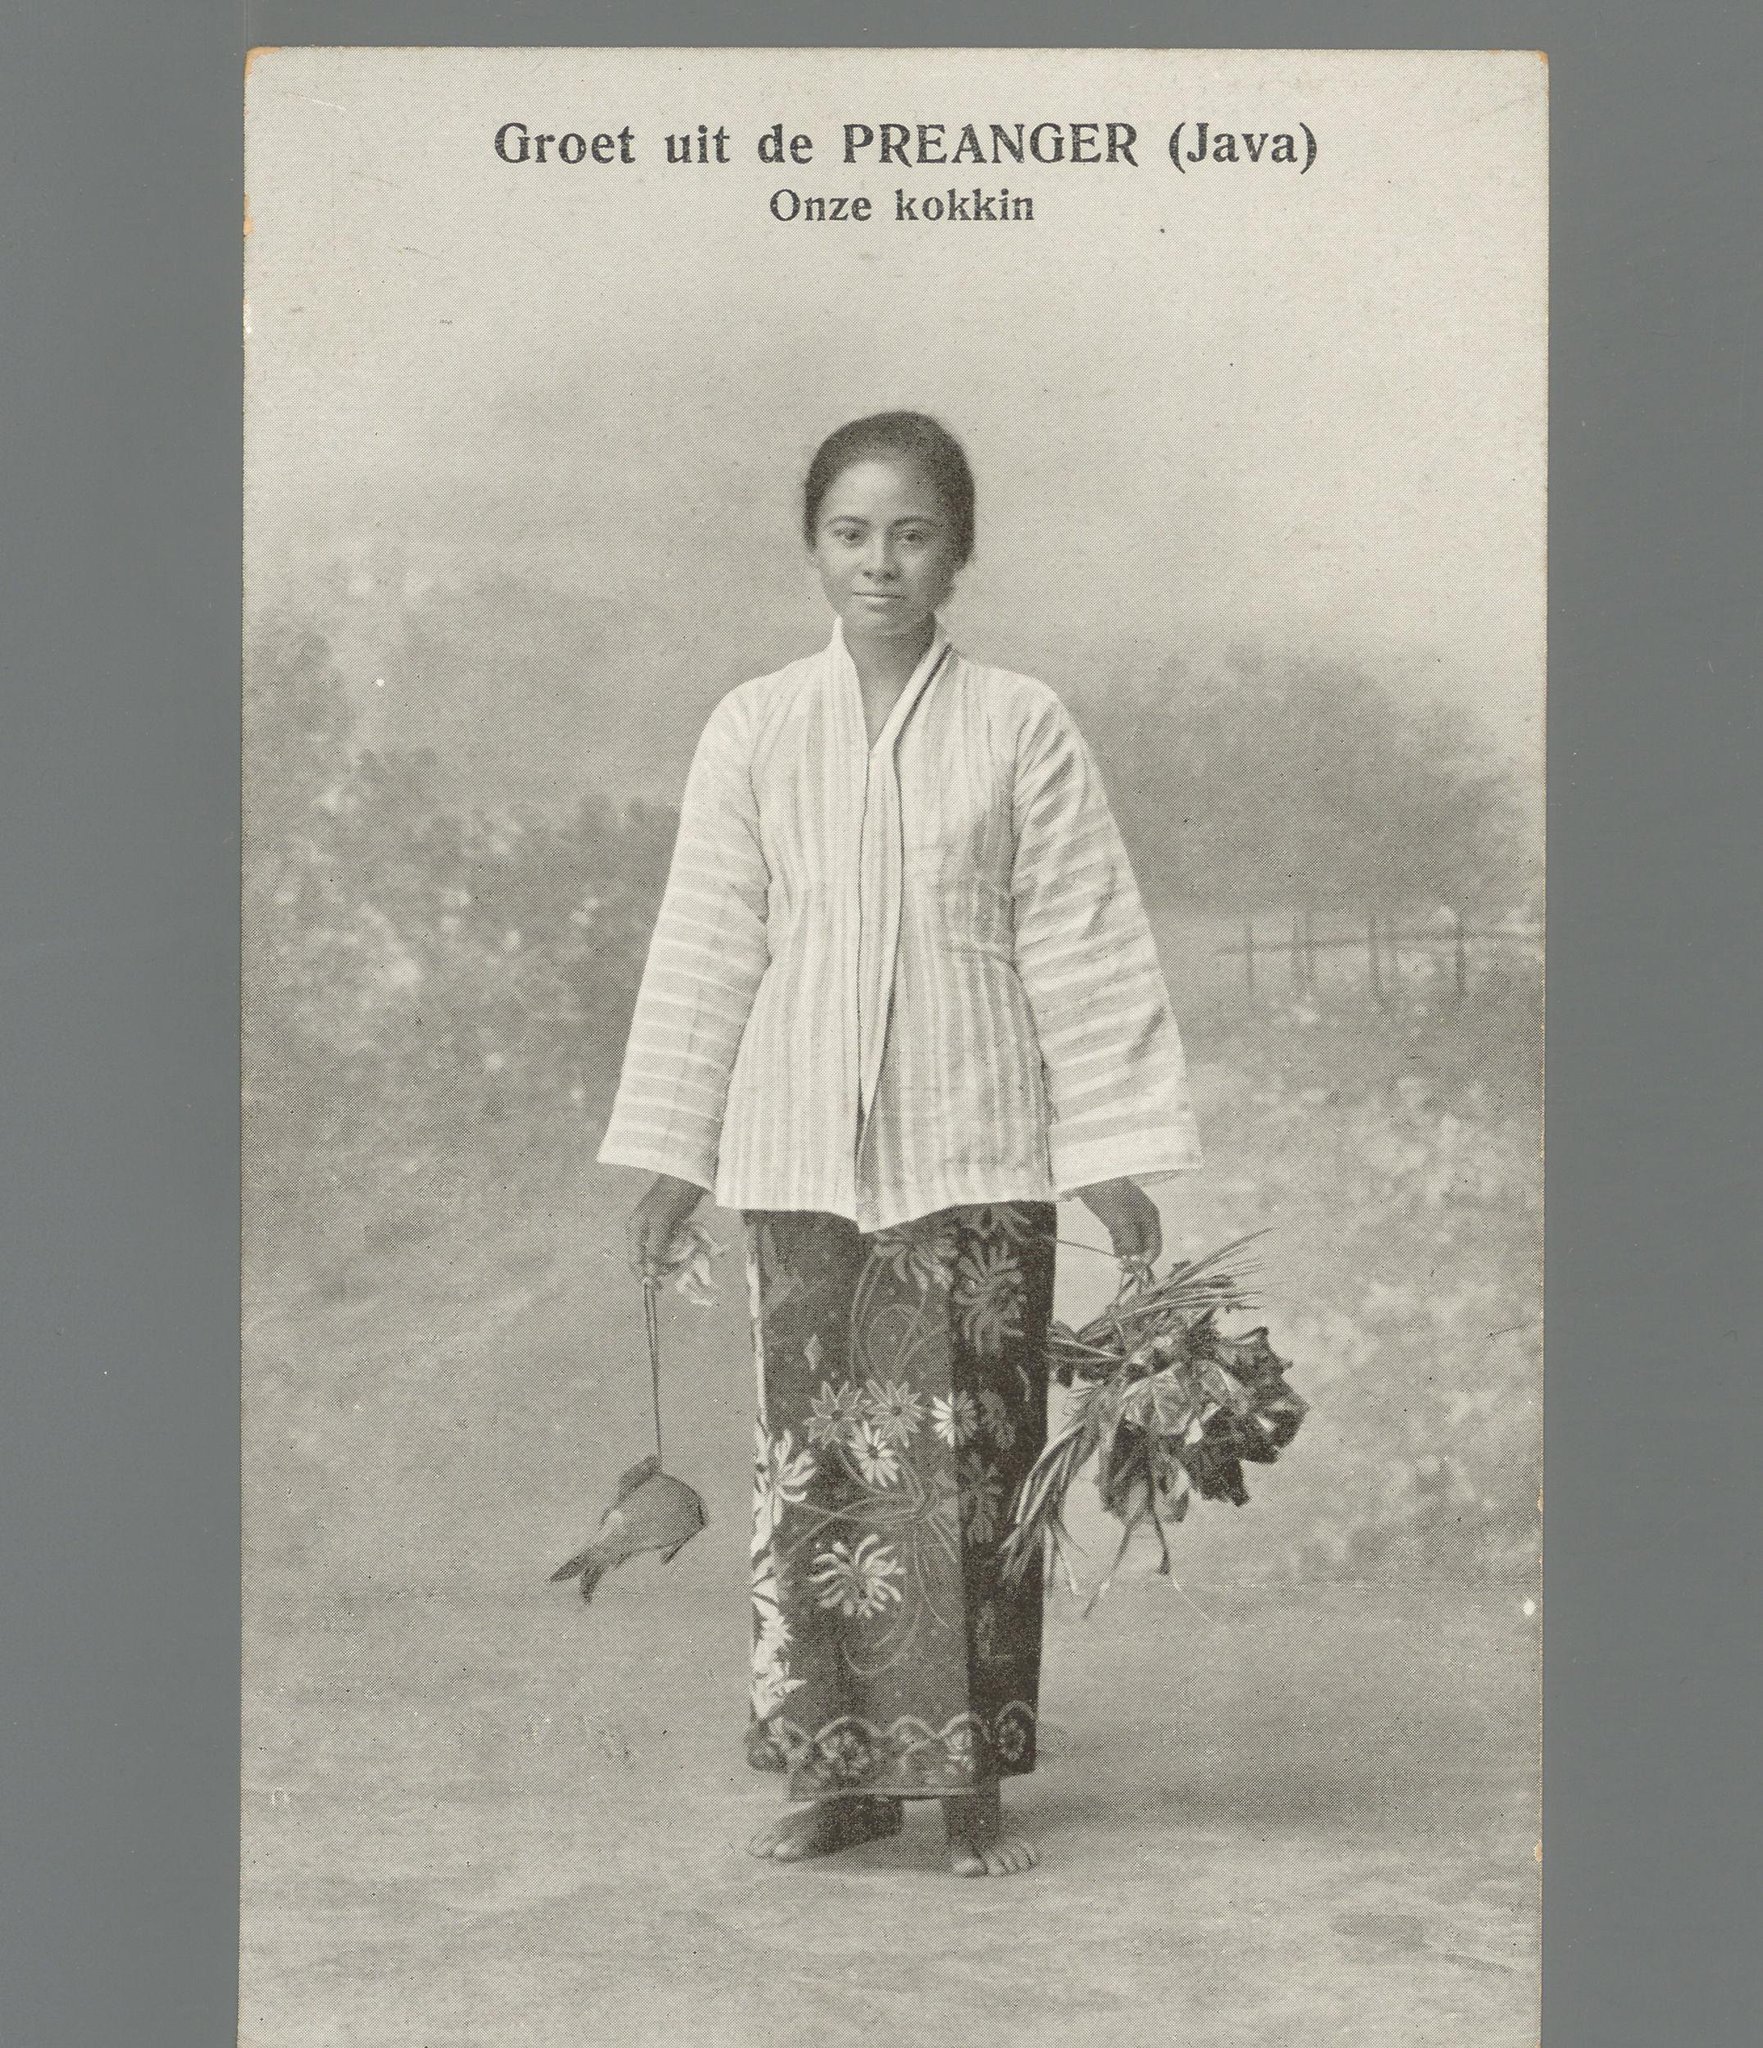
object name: photomechanical print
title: Groet uit de Preanger (Java). Onze kokkin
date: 1906-1930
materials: cardboard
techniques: autotype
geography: weltevreden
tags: fashion, clothing, dyeing of cloth with pattern; batik-work